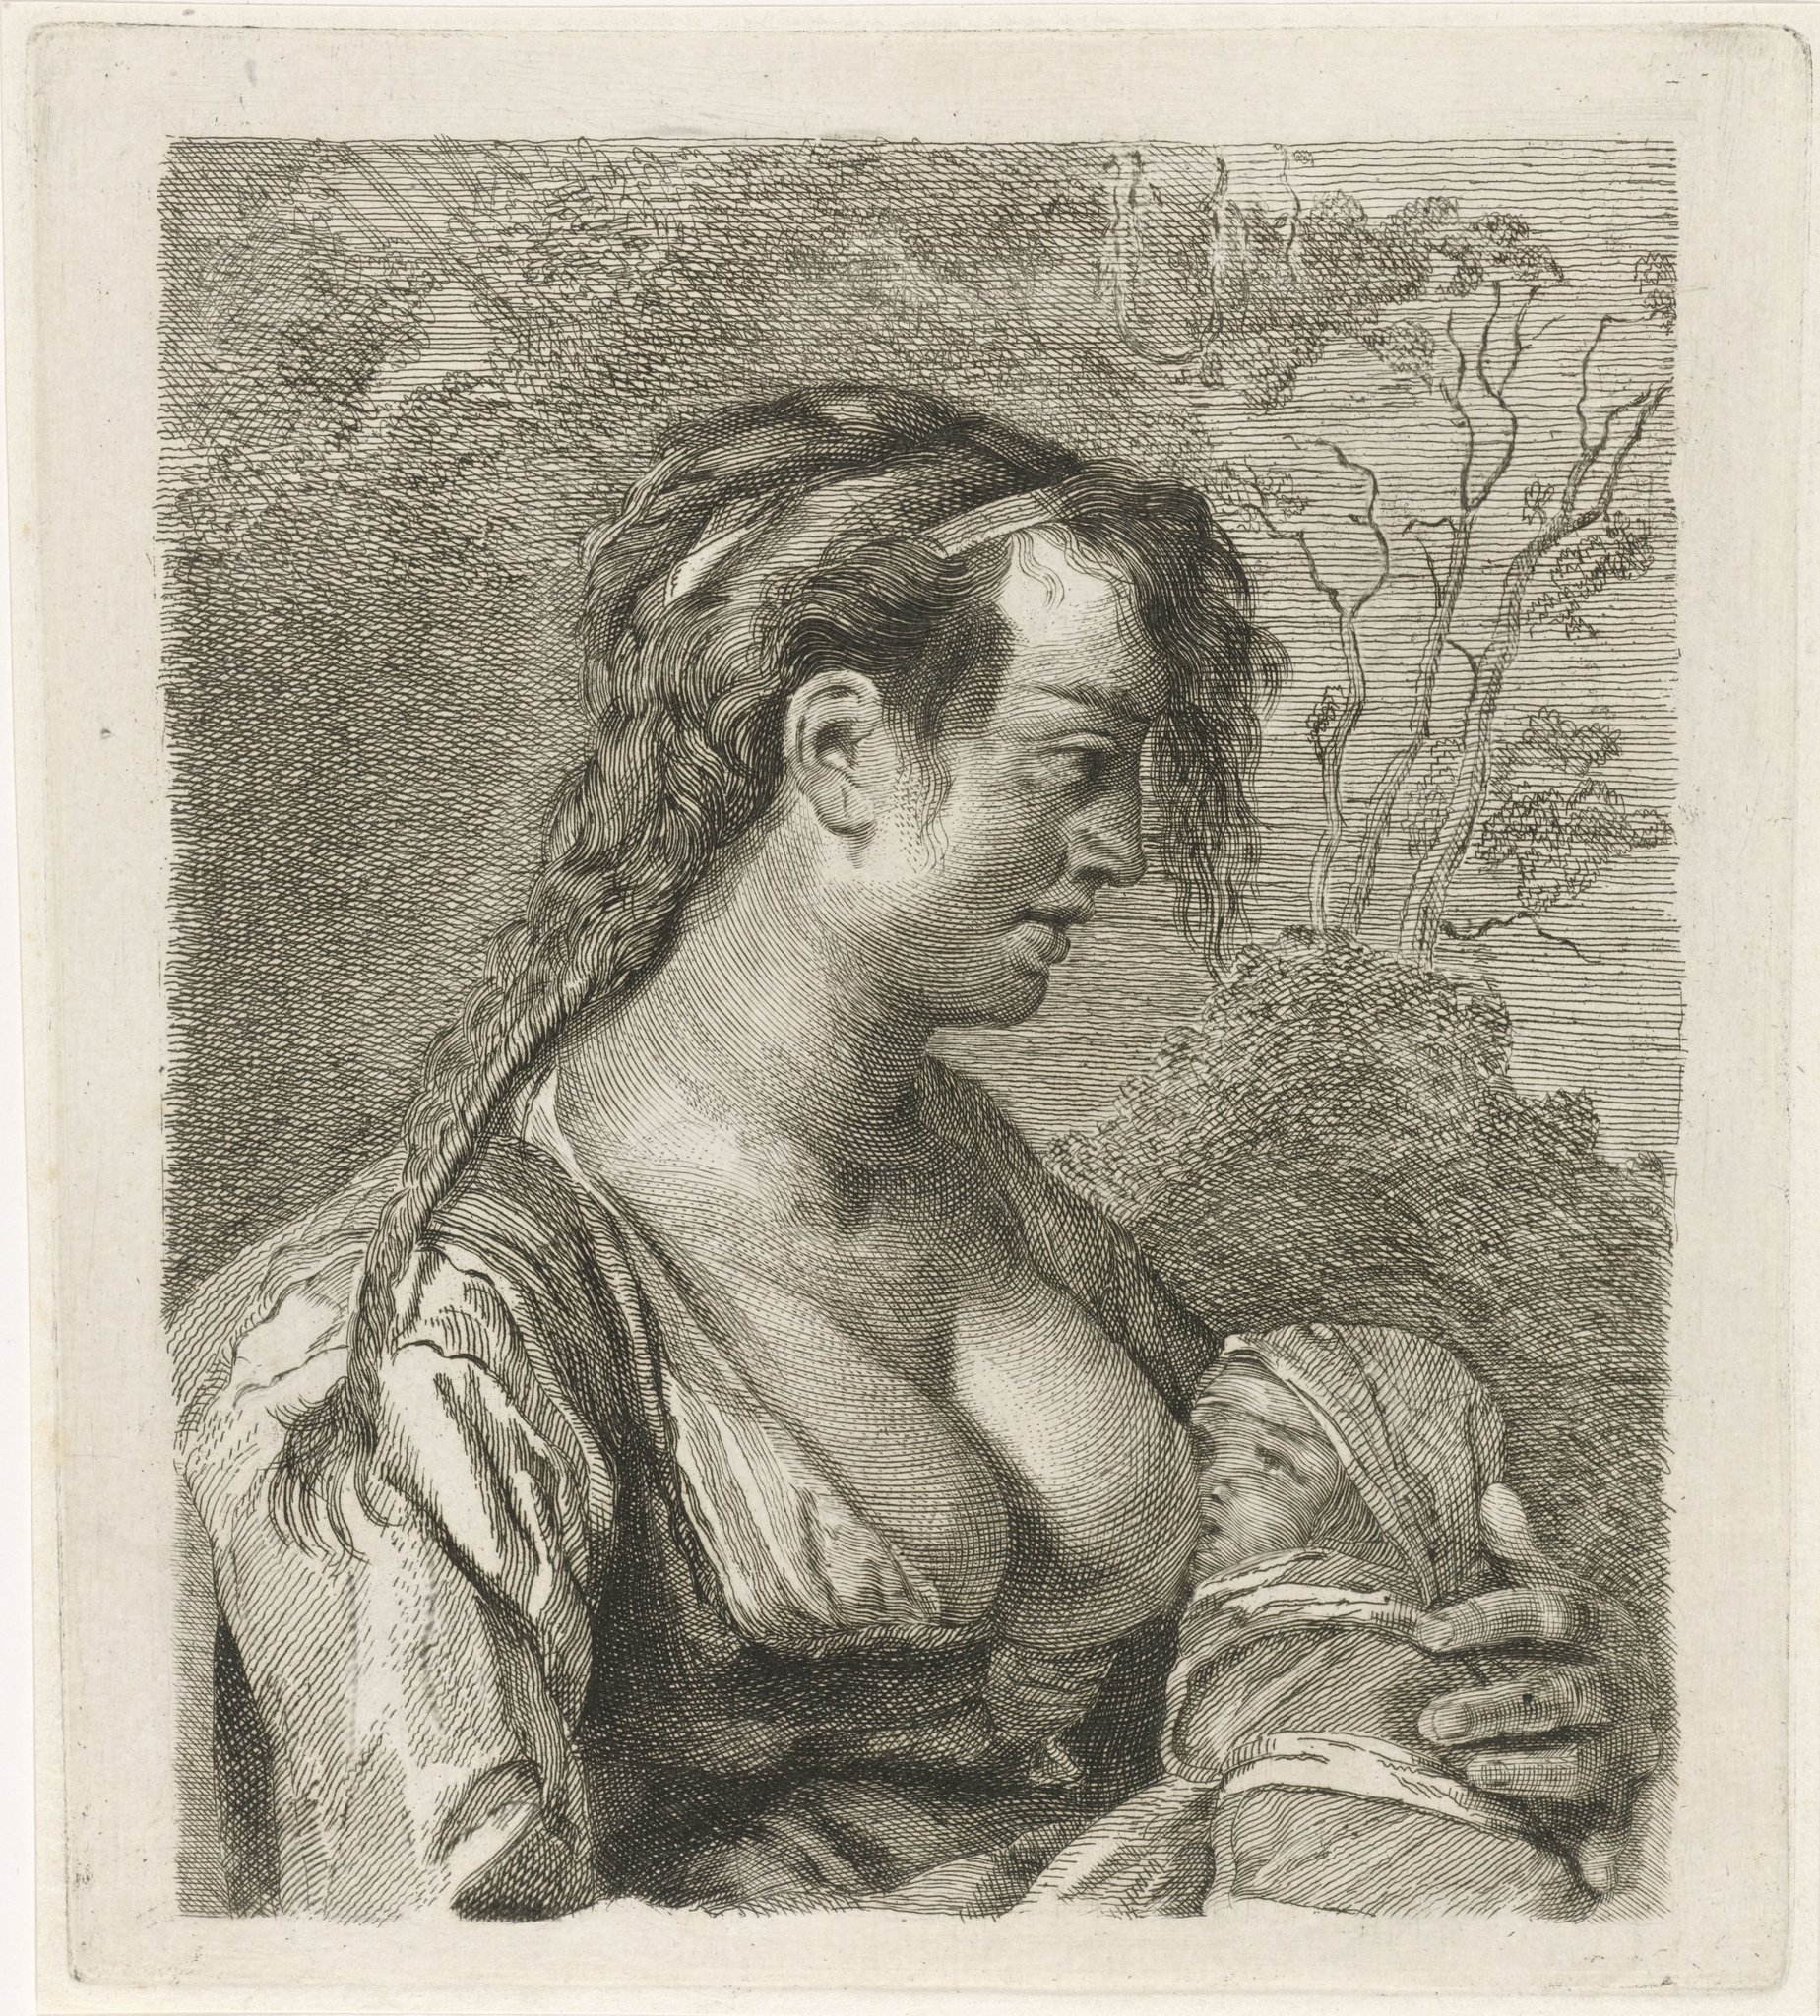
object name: print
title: Zogende moeder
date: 1768-1796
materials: paper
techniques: engraving, etching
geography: leiden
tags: nursing, suckling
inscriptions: collector's mark: Lugt 240